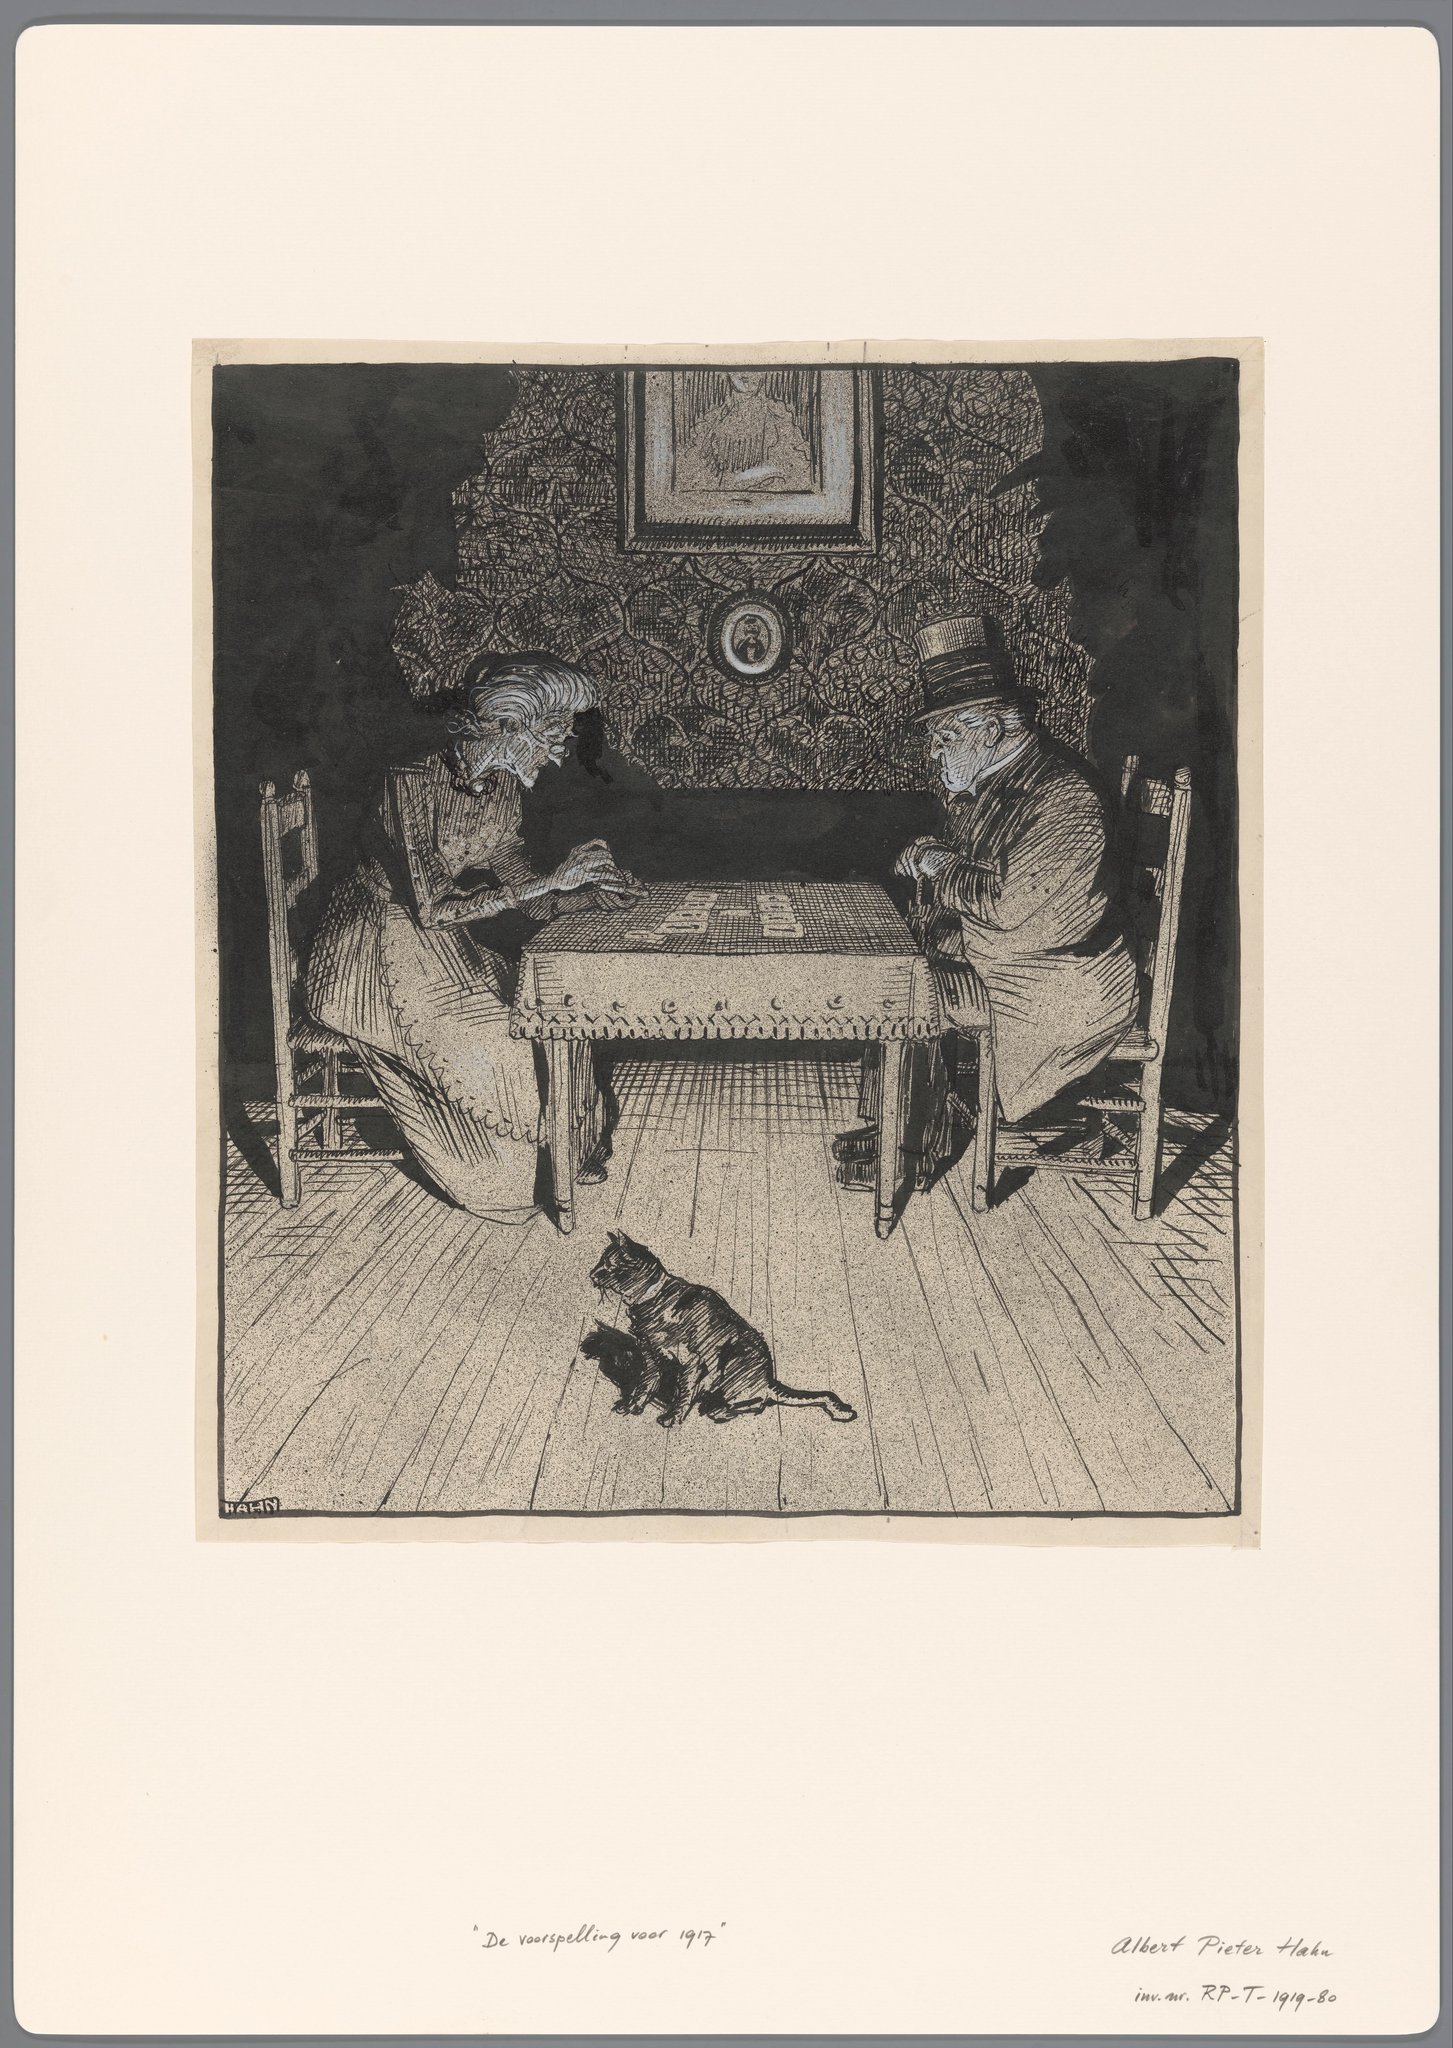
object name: design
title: Ontwerp voor een politieke spotprent: De Voorspelling voor 1917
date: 1887-1919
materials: chalk, paint, ink, paper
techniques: brush, pen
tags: card games (+ sportsman, player, etc.), political caricatures and satires